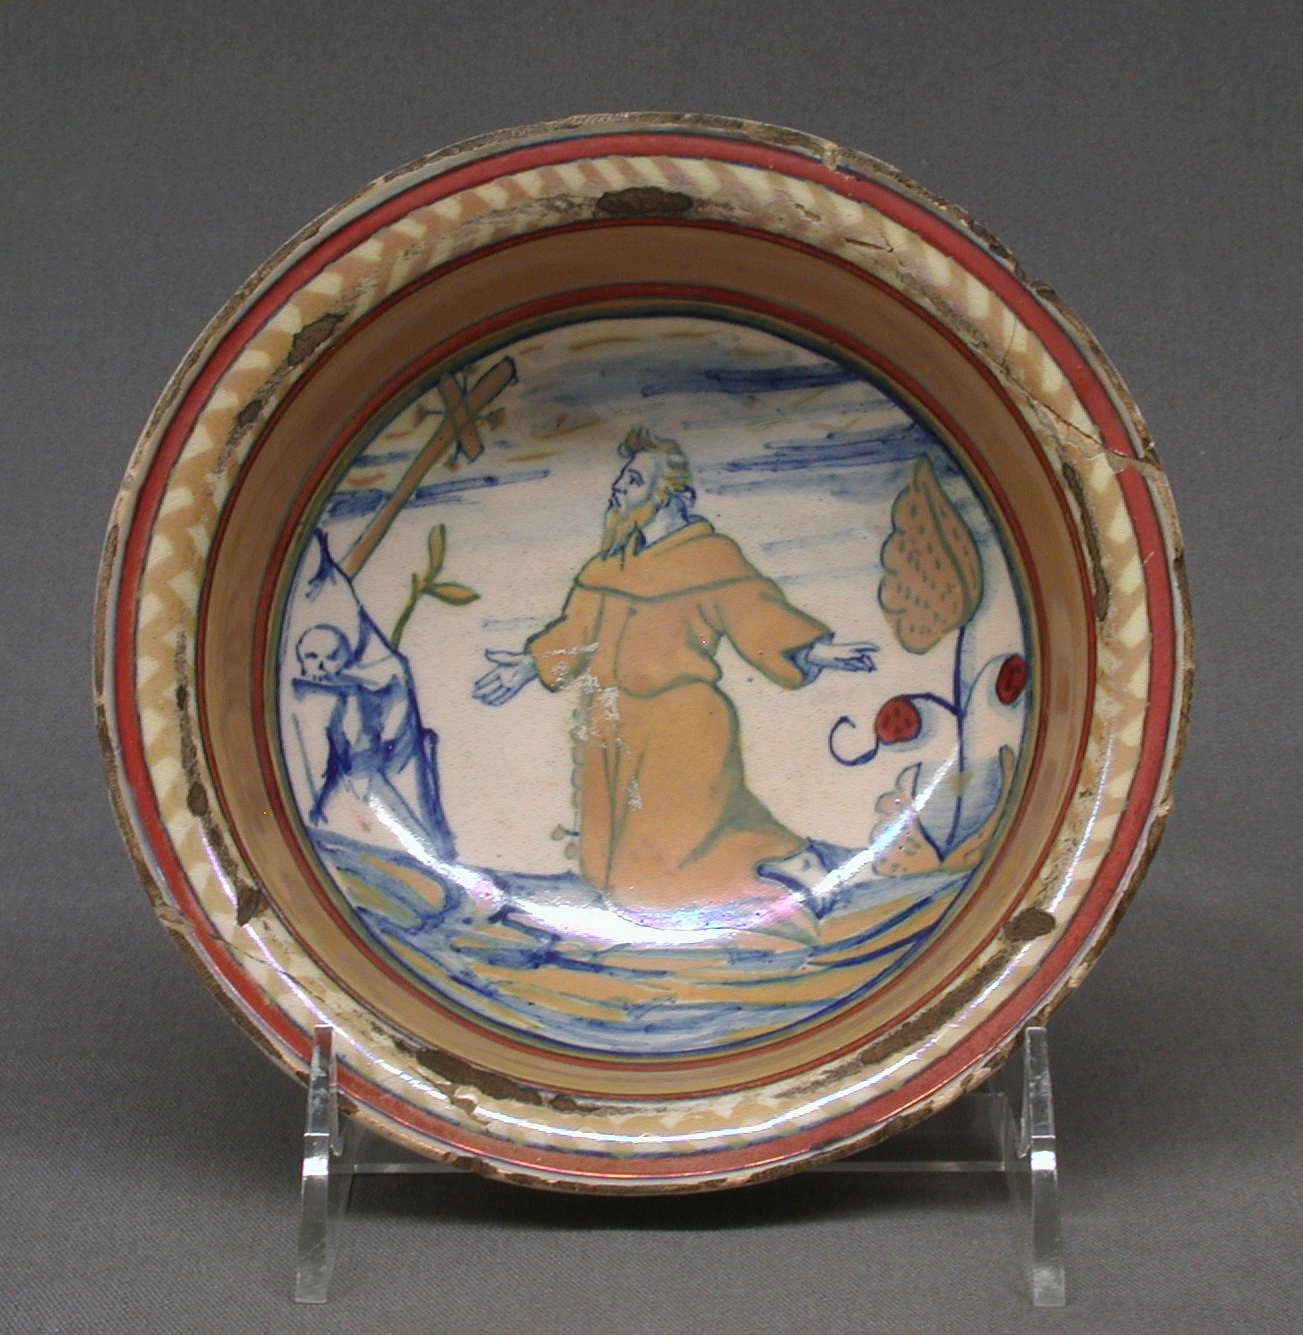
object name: bowl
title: Bowl with Saint Francis receiving the stigmata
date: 1501-1600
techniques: maiolica, glazing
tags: saint francis